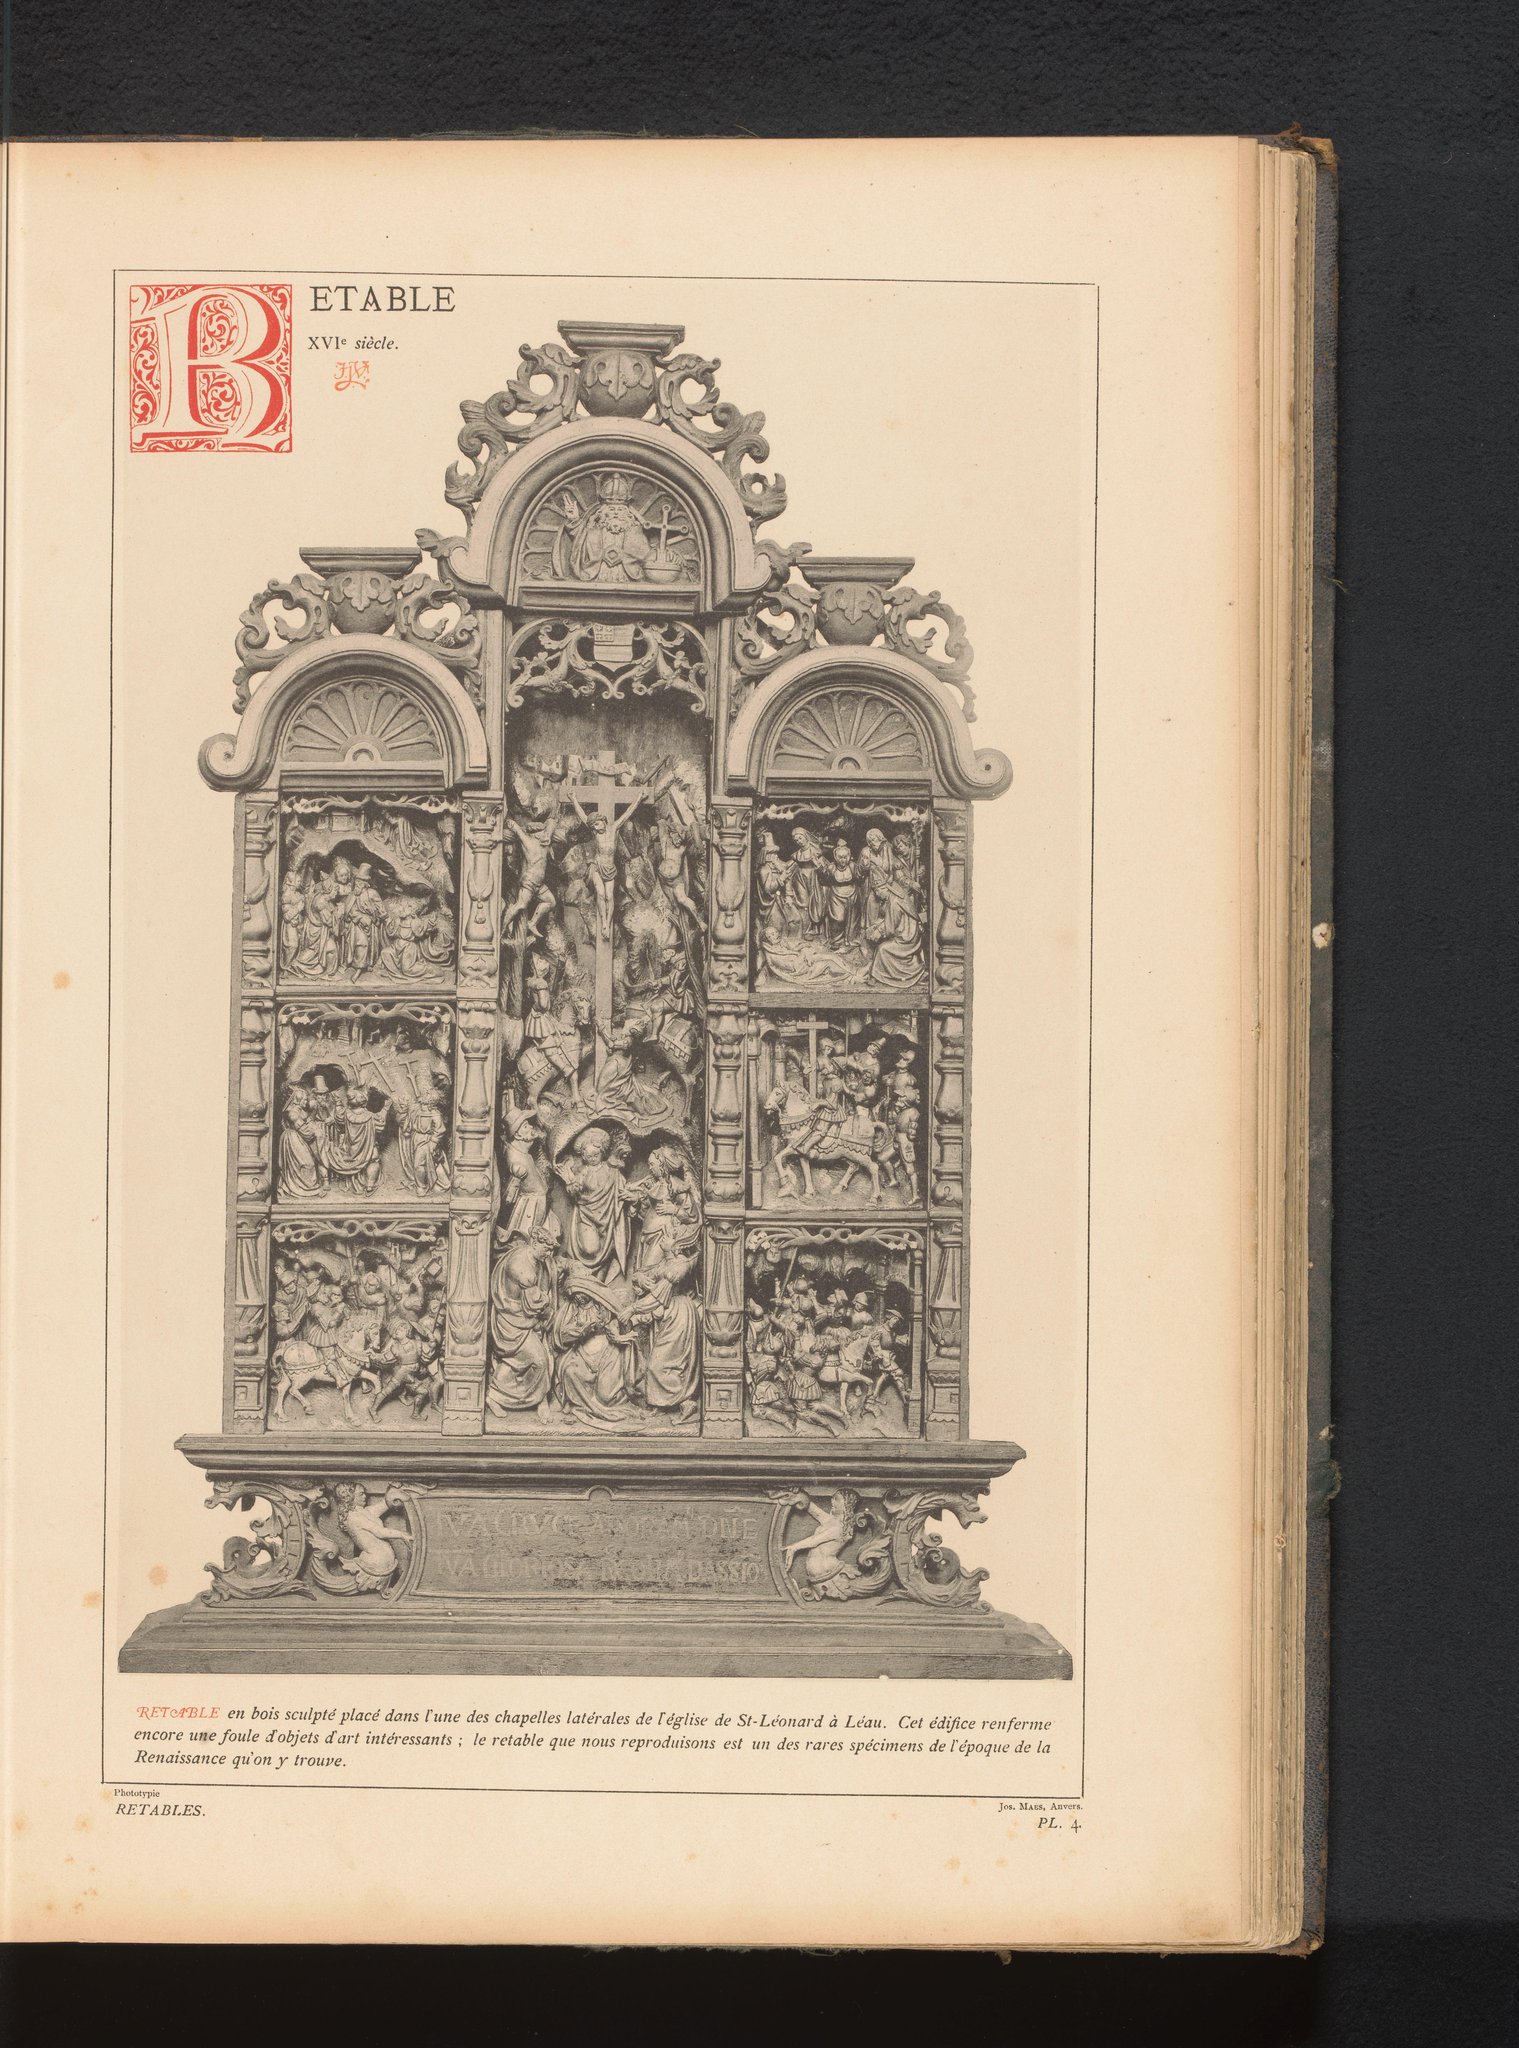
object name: page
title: Altaarstuk van hout in de Sint-Leonarduskerk in Zoutleeuw, België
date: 1882-1887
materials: paper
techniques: photograph, photolithography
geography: zoutleeuw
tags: altar with altar-piece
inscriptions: monogram: ‘JJvY’, inscription: ‘RETABLES. - PL. 4.’, inscription: ‘RETABLE en bois (...)’